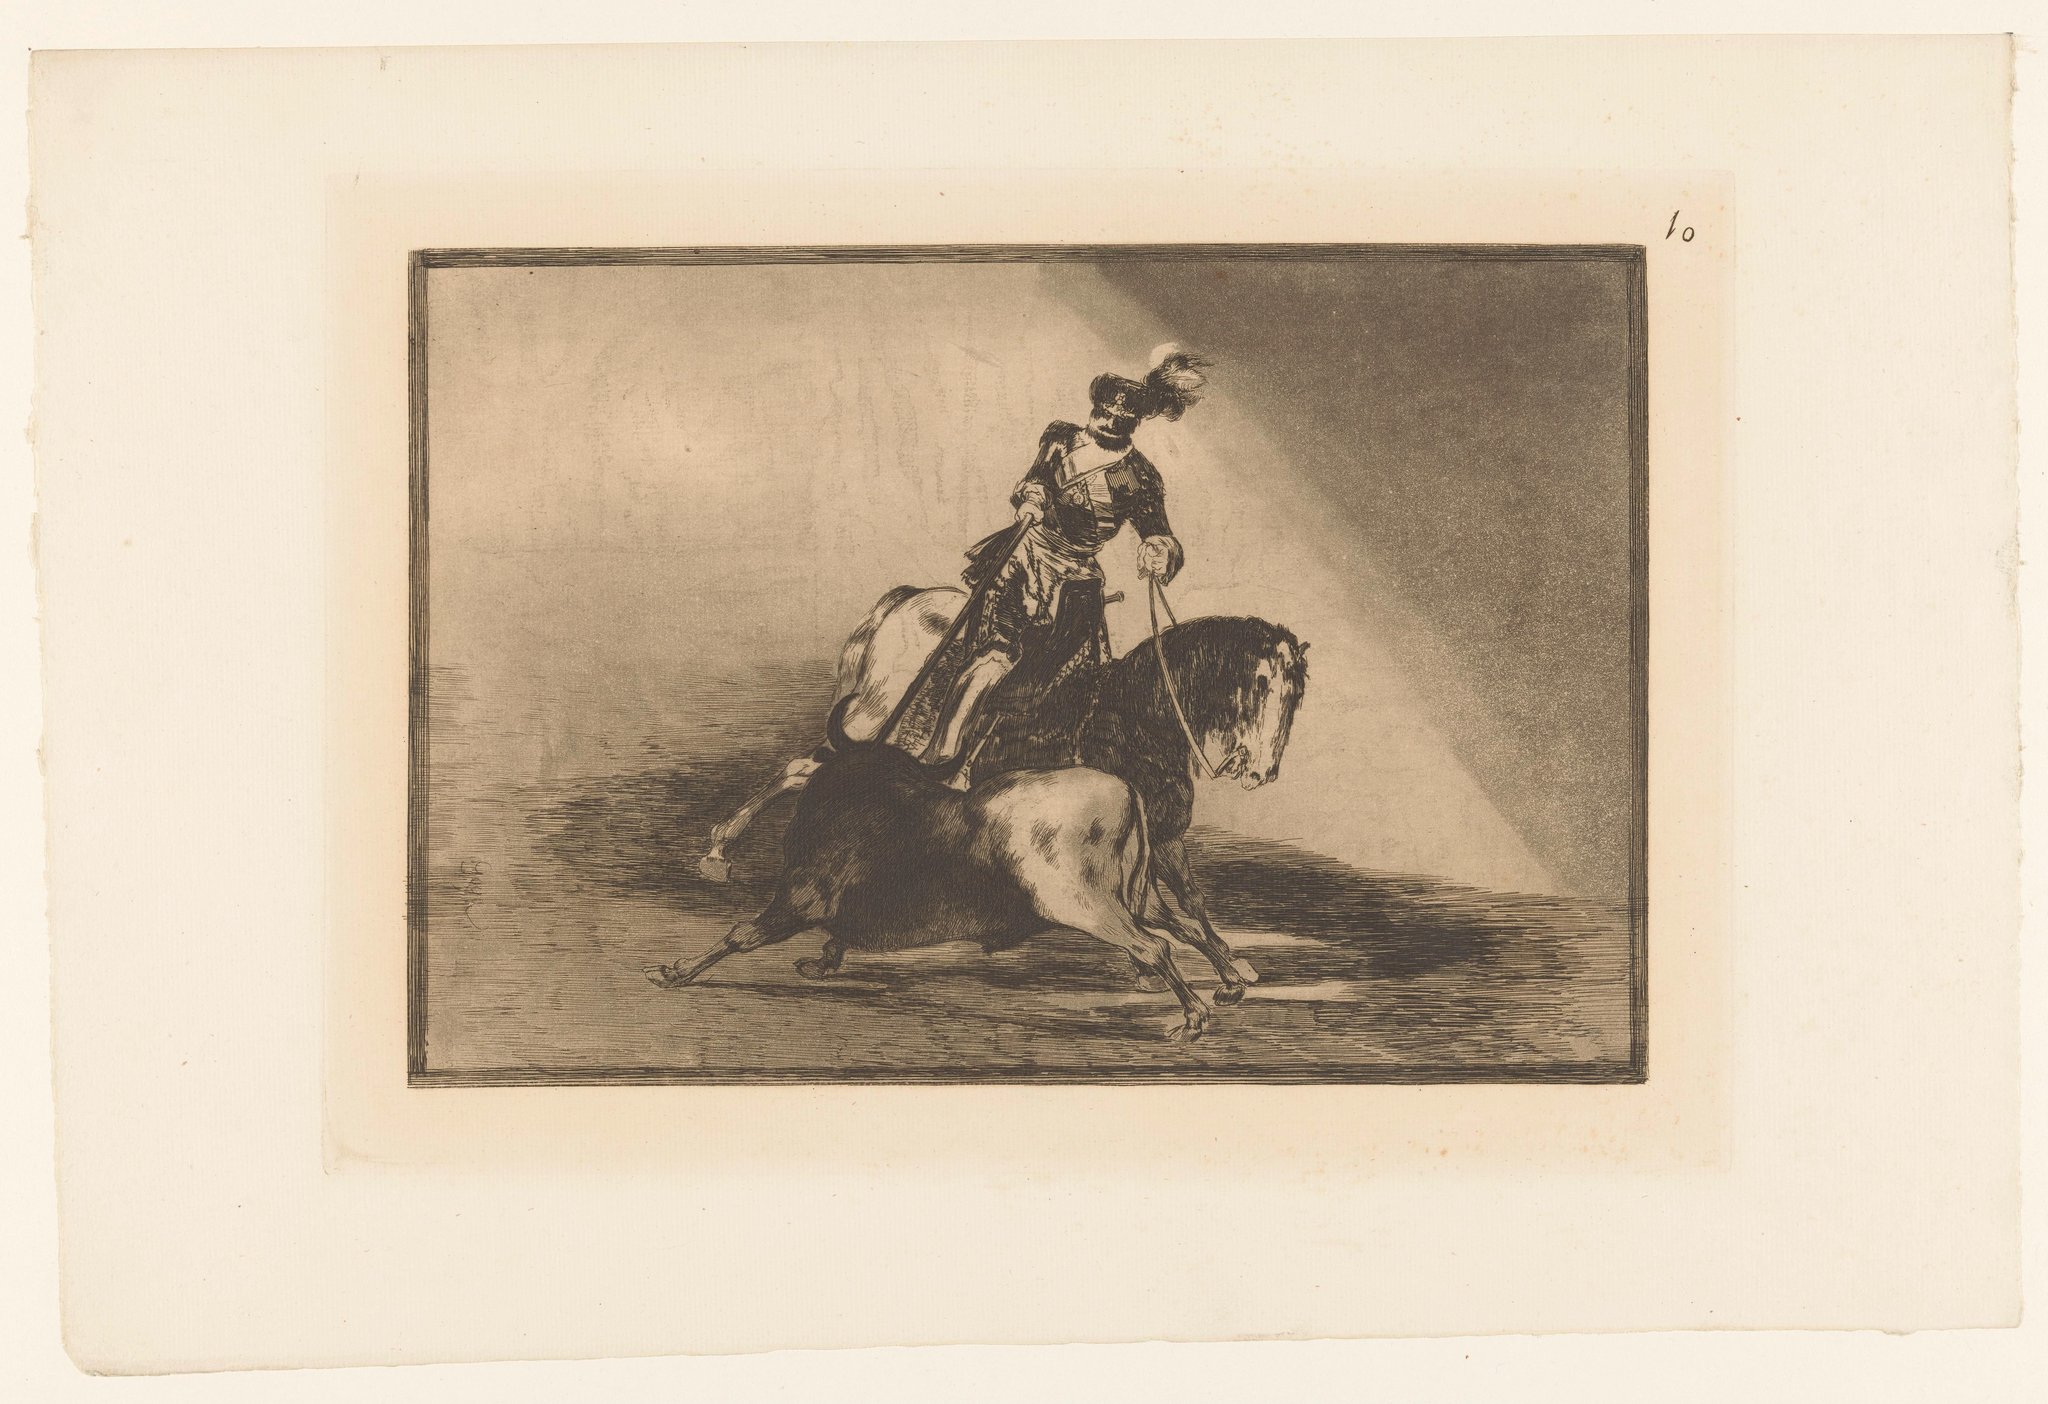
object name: print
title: Keizer Karel V in gevecht met een stier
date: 1876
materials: paper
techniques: aquatint, etching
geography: paris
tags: charles v (holy roman emperor and king of spain), riding a horse, ass, or mule; rider, horseman, bull, bullfight, emperor, ruler, sovereign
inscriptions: collector's mark: Lugt 2228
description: Deze prent maakt deel uit van een serie van 40 prenten door Francisco de Goya met voorstellingen van stierengevechten. De eerste editie bestond uit 33 genummerde prenten en werd uitgegeven in 1816. Dit betreft de derde editie, uitgegeven in 1876 door Eugène Loizelet en door hem voorzien van een titelprent en lijst met titels. Naast de 33 prenten publiceerde Loizelet ook de prenten die door Goya op de achterkanten van 7 van de platen werden geëtst. Deze zijn niet voorzien van nummers maar van de letters A-G.